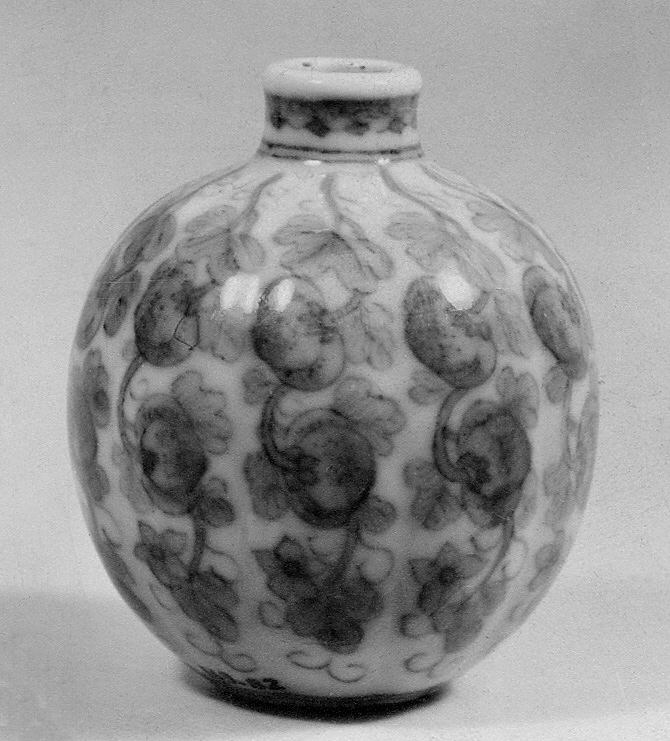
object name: snuff bottle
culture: chinese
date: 1723-1735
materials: porcelain